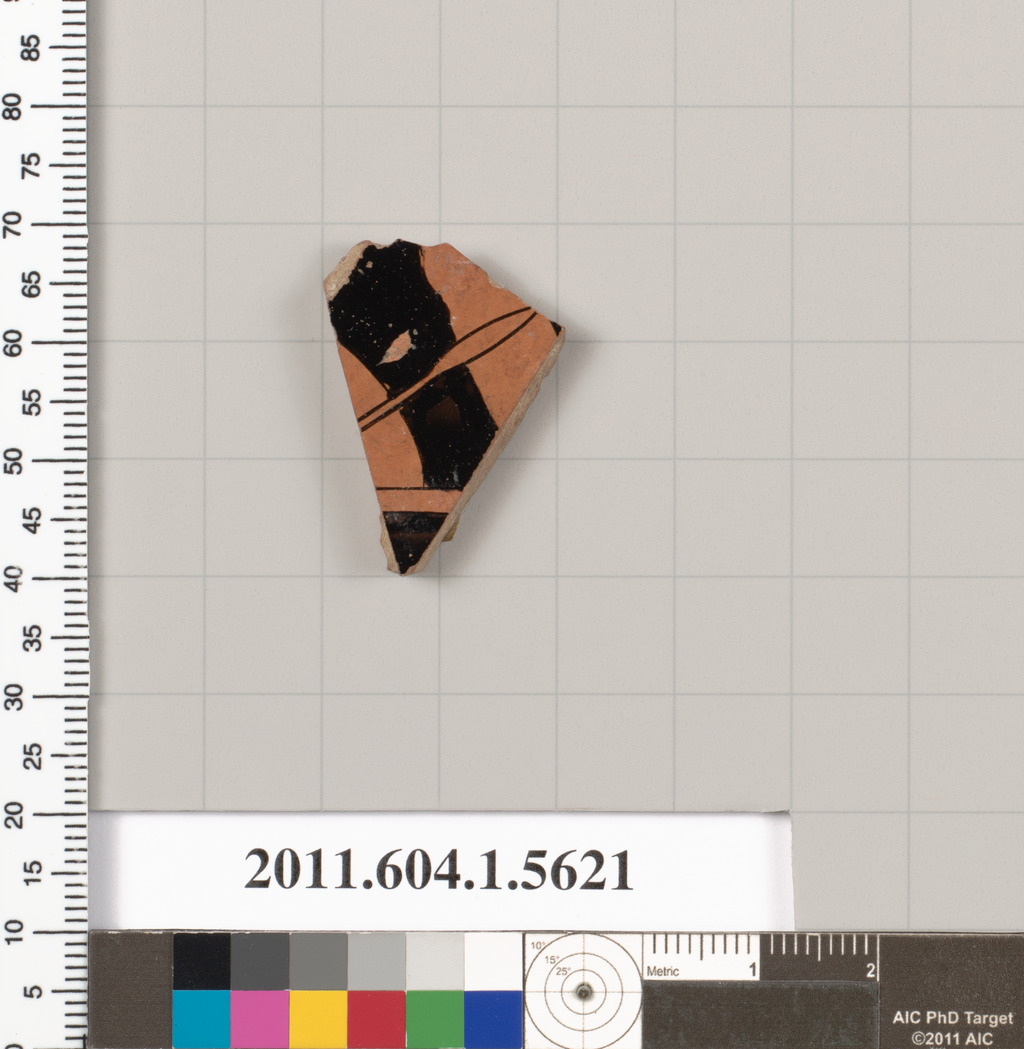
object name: kylix fragment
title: Terracotta fragment of a kylix (drinking cup)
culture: greek, attic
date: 520-490 BCE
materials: terracotta